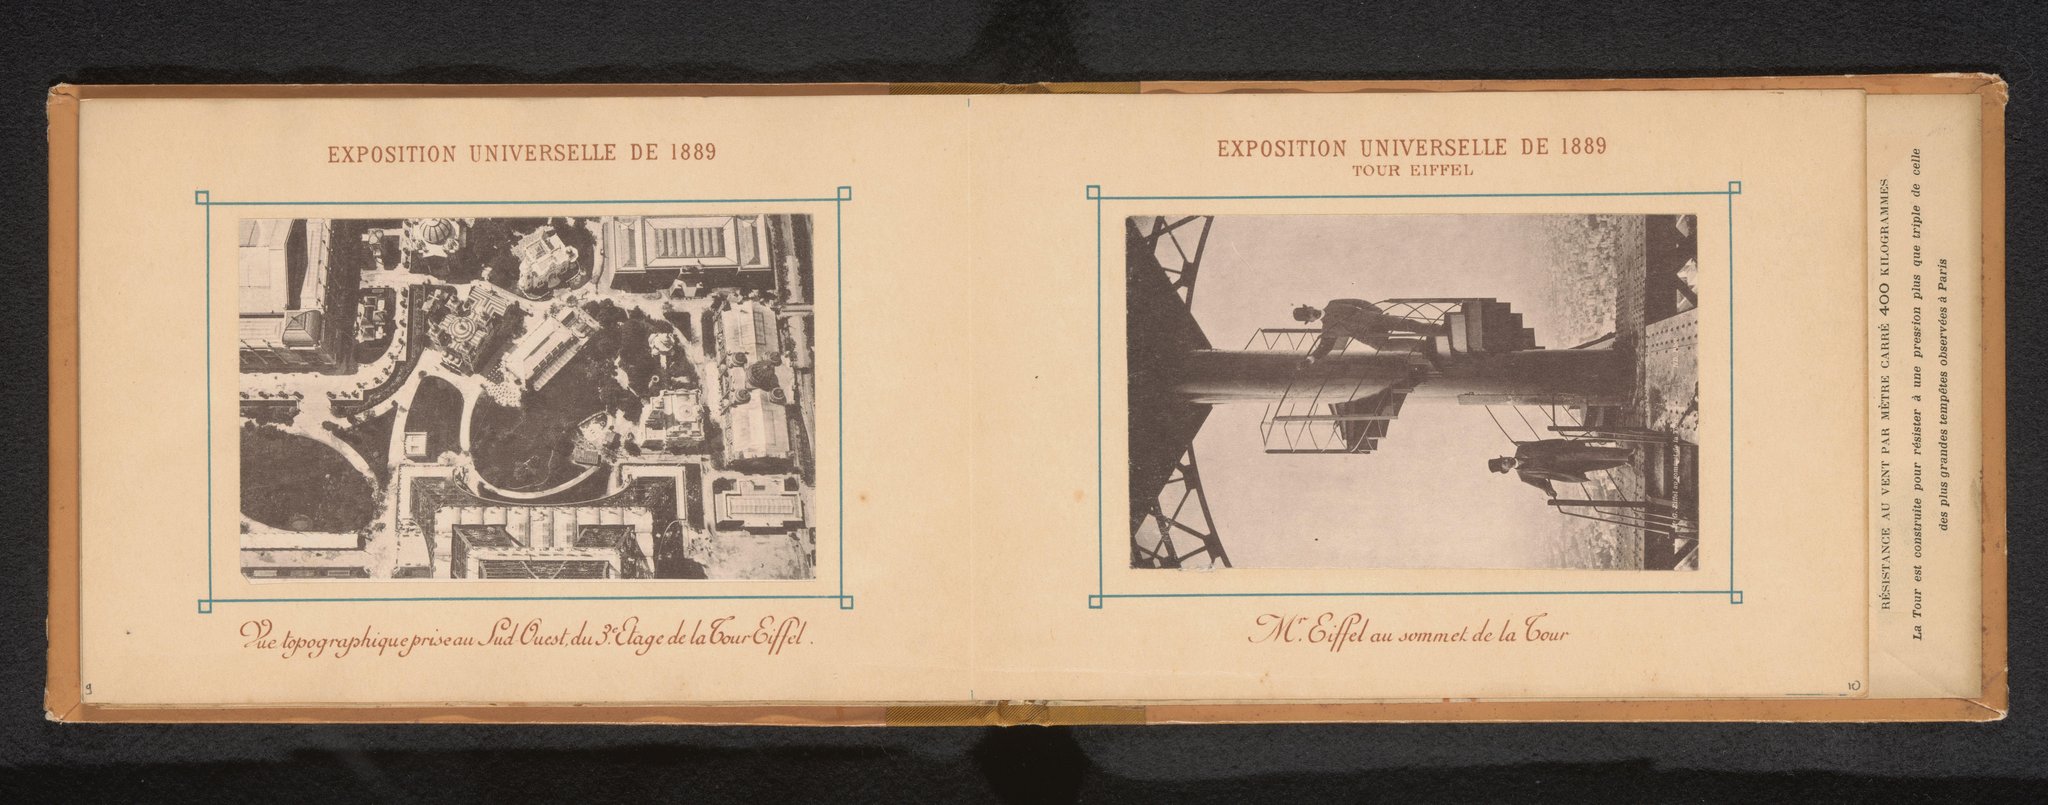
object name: page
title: Exposition Universelle de 1889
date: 1889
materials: paper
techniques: photograph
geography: paris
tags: city-view, and landscape with man-made constructions, paris